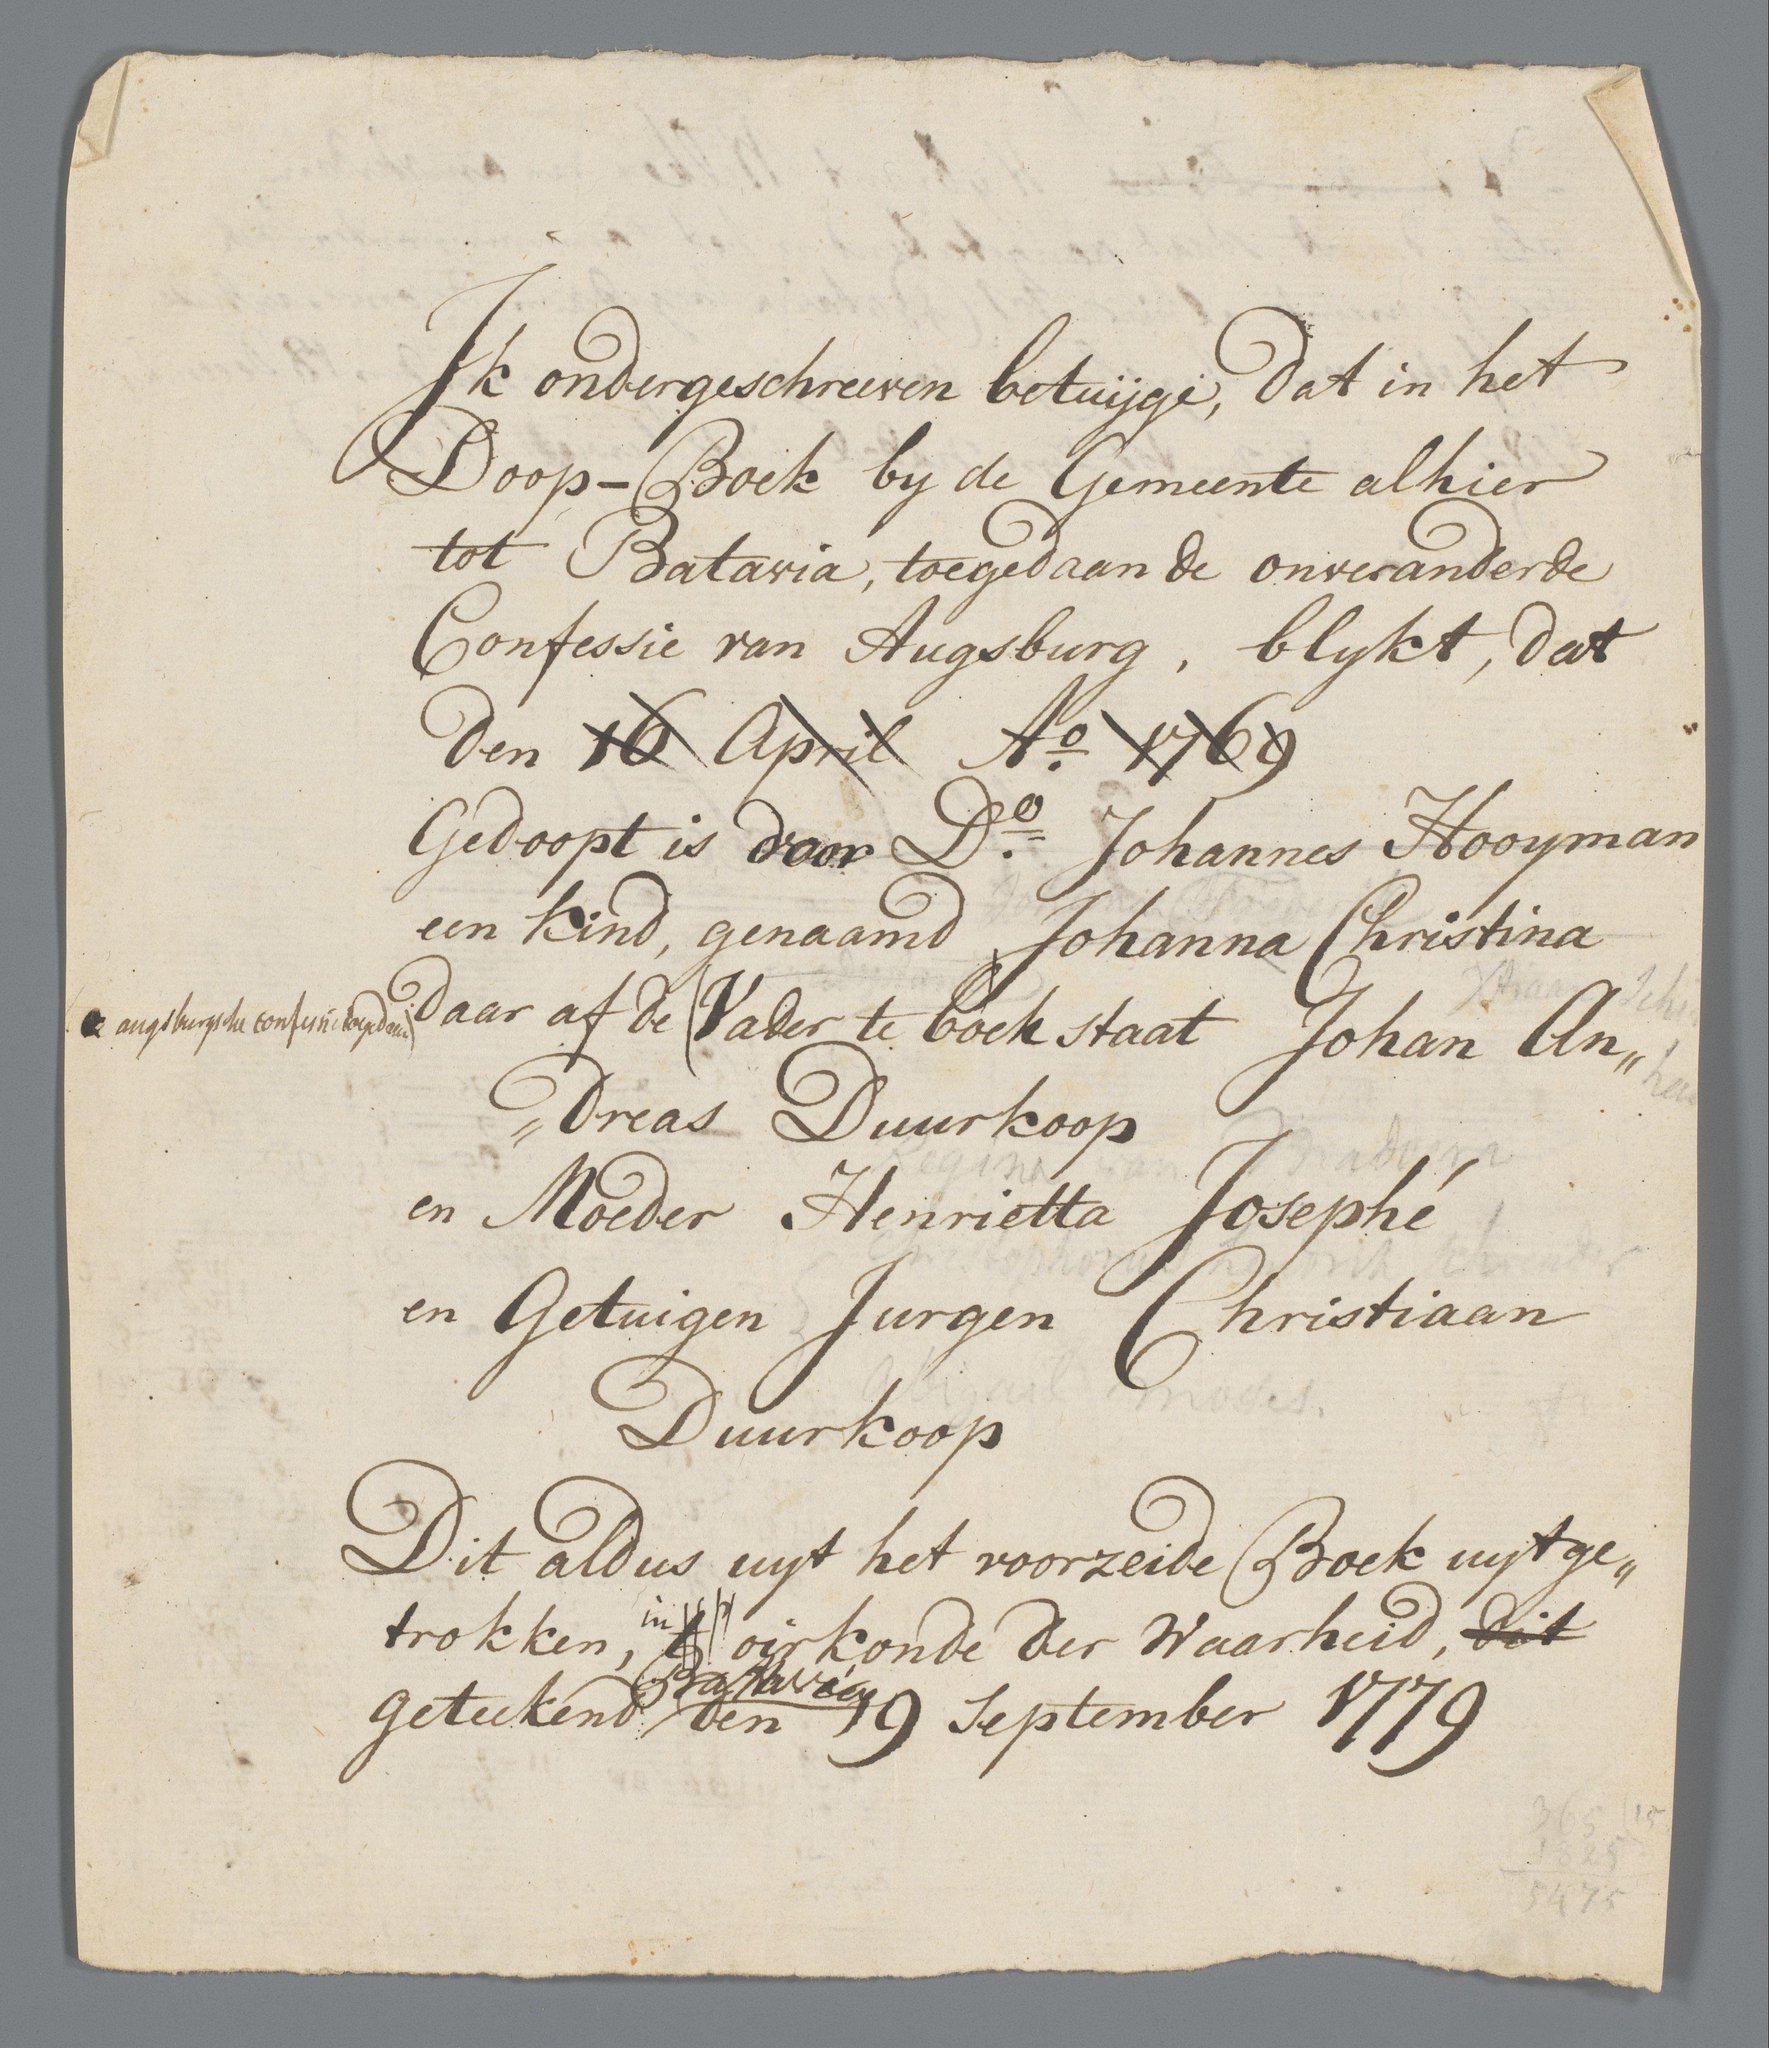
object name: letter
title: Uittreksel uit het doopregister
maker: Anonymous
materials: ink, paper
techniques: pen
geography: batavia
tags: bodegraven, draughtsman, jan brandes, batavia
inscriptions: date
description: Blaadje op twee zijden beschreven. Recto: uittreksel uit het doopregister van Johanna Christina Duurkoop (gedoopt 16 april 1769) van 19 september 1779. Verso: bevestiging van de inschrijving van J.H. Borbecker als lidmaat van de lutherse kerk te Batavia, 18 december 1782. Onderdeel van een groep papieren van Jan Brandes uit zijn tijd als predikant bij de lutherse kerk te Batavia 1779-1785.